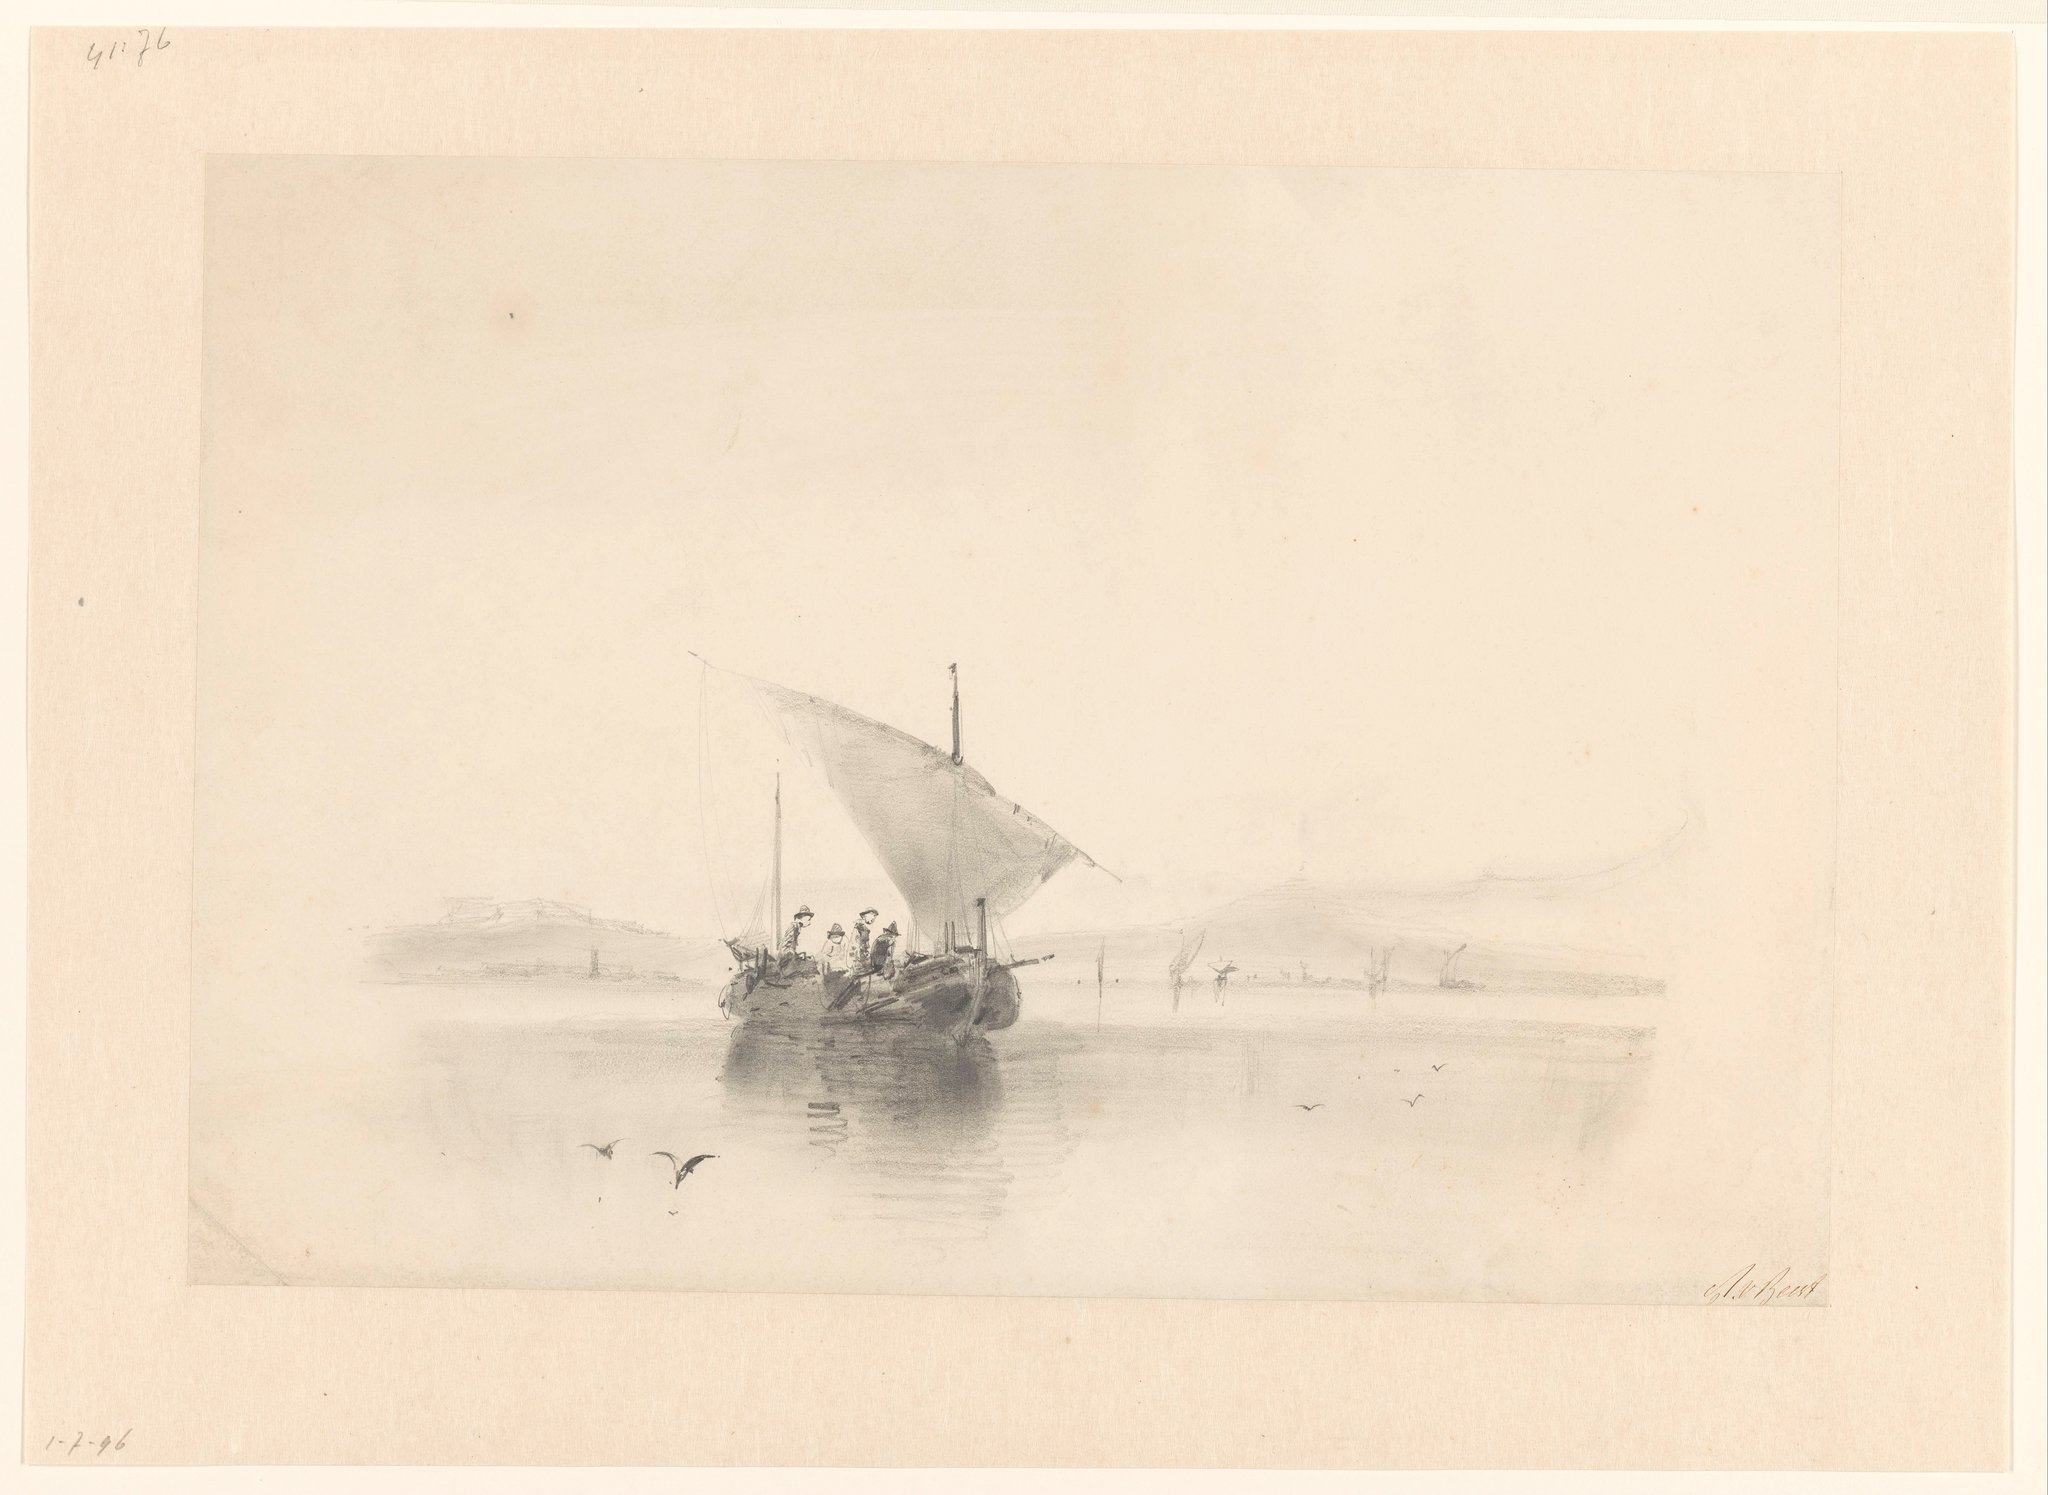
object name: drawing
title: Vissersbootje voor de kust op kalme zee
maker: albertus van beest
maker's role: draughtsman, print maker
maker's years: 1820-1860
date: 1830-1860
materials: paper, pencil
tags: sailing-ship, sailing-boat, sea (seascape)